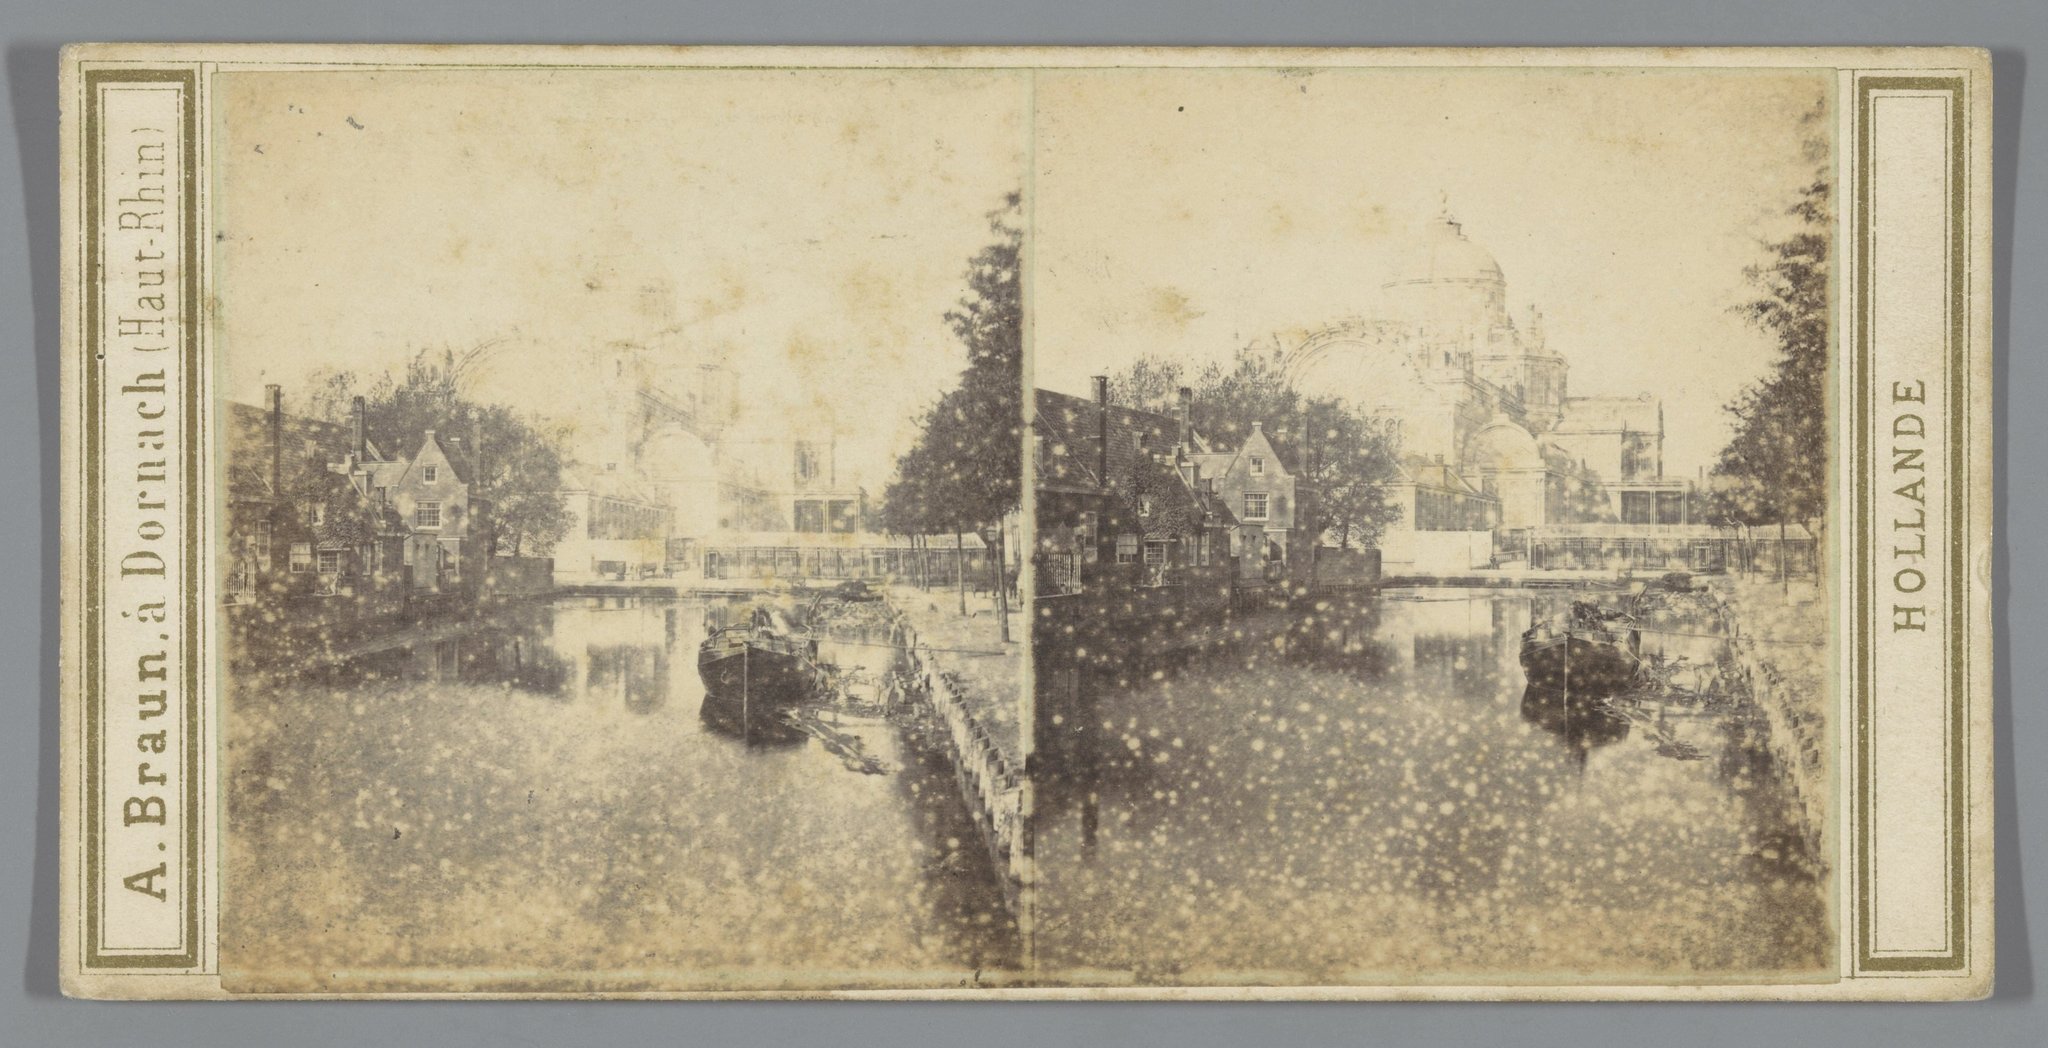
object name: stereograph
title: Amsterdam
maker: gaston braun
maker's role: fotograaf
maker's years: 1845-1928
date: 1864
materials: cardboard, paper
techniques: albumen print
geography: dornach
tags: palace, canals, waters (in city)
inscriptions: inscription: ‘B. 3 April 1865.’, number: ‘No. 3991.’